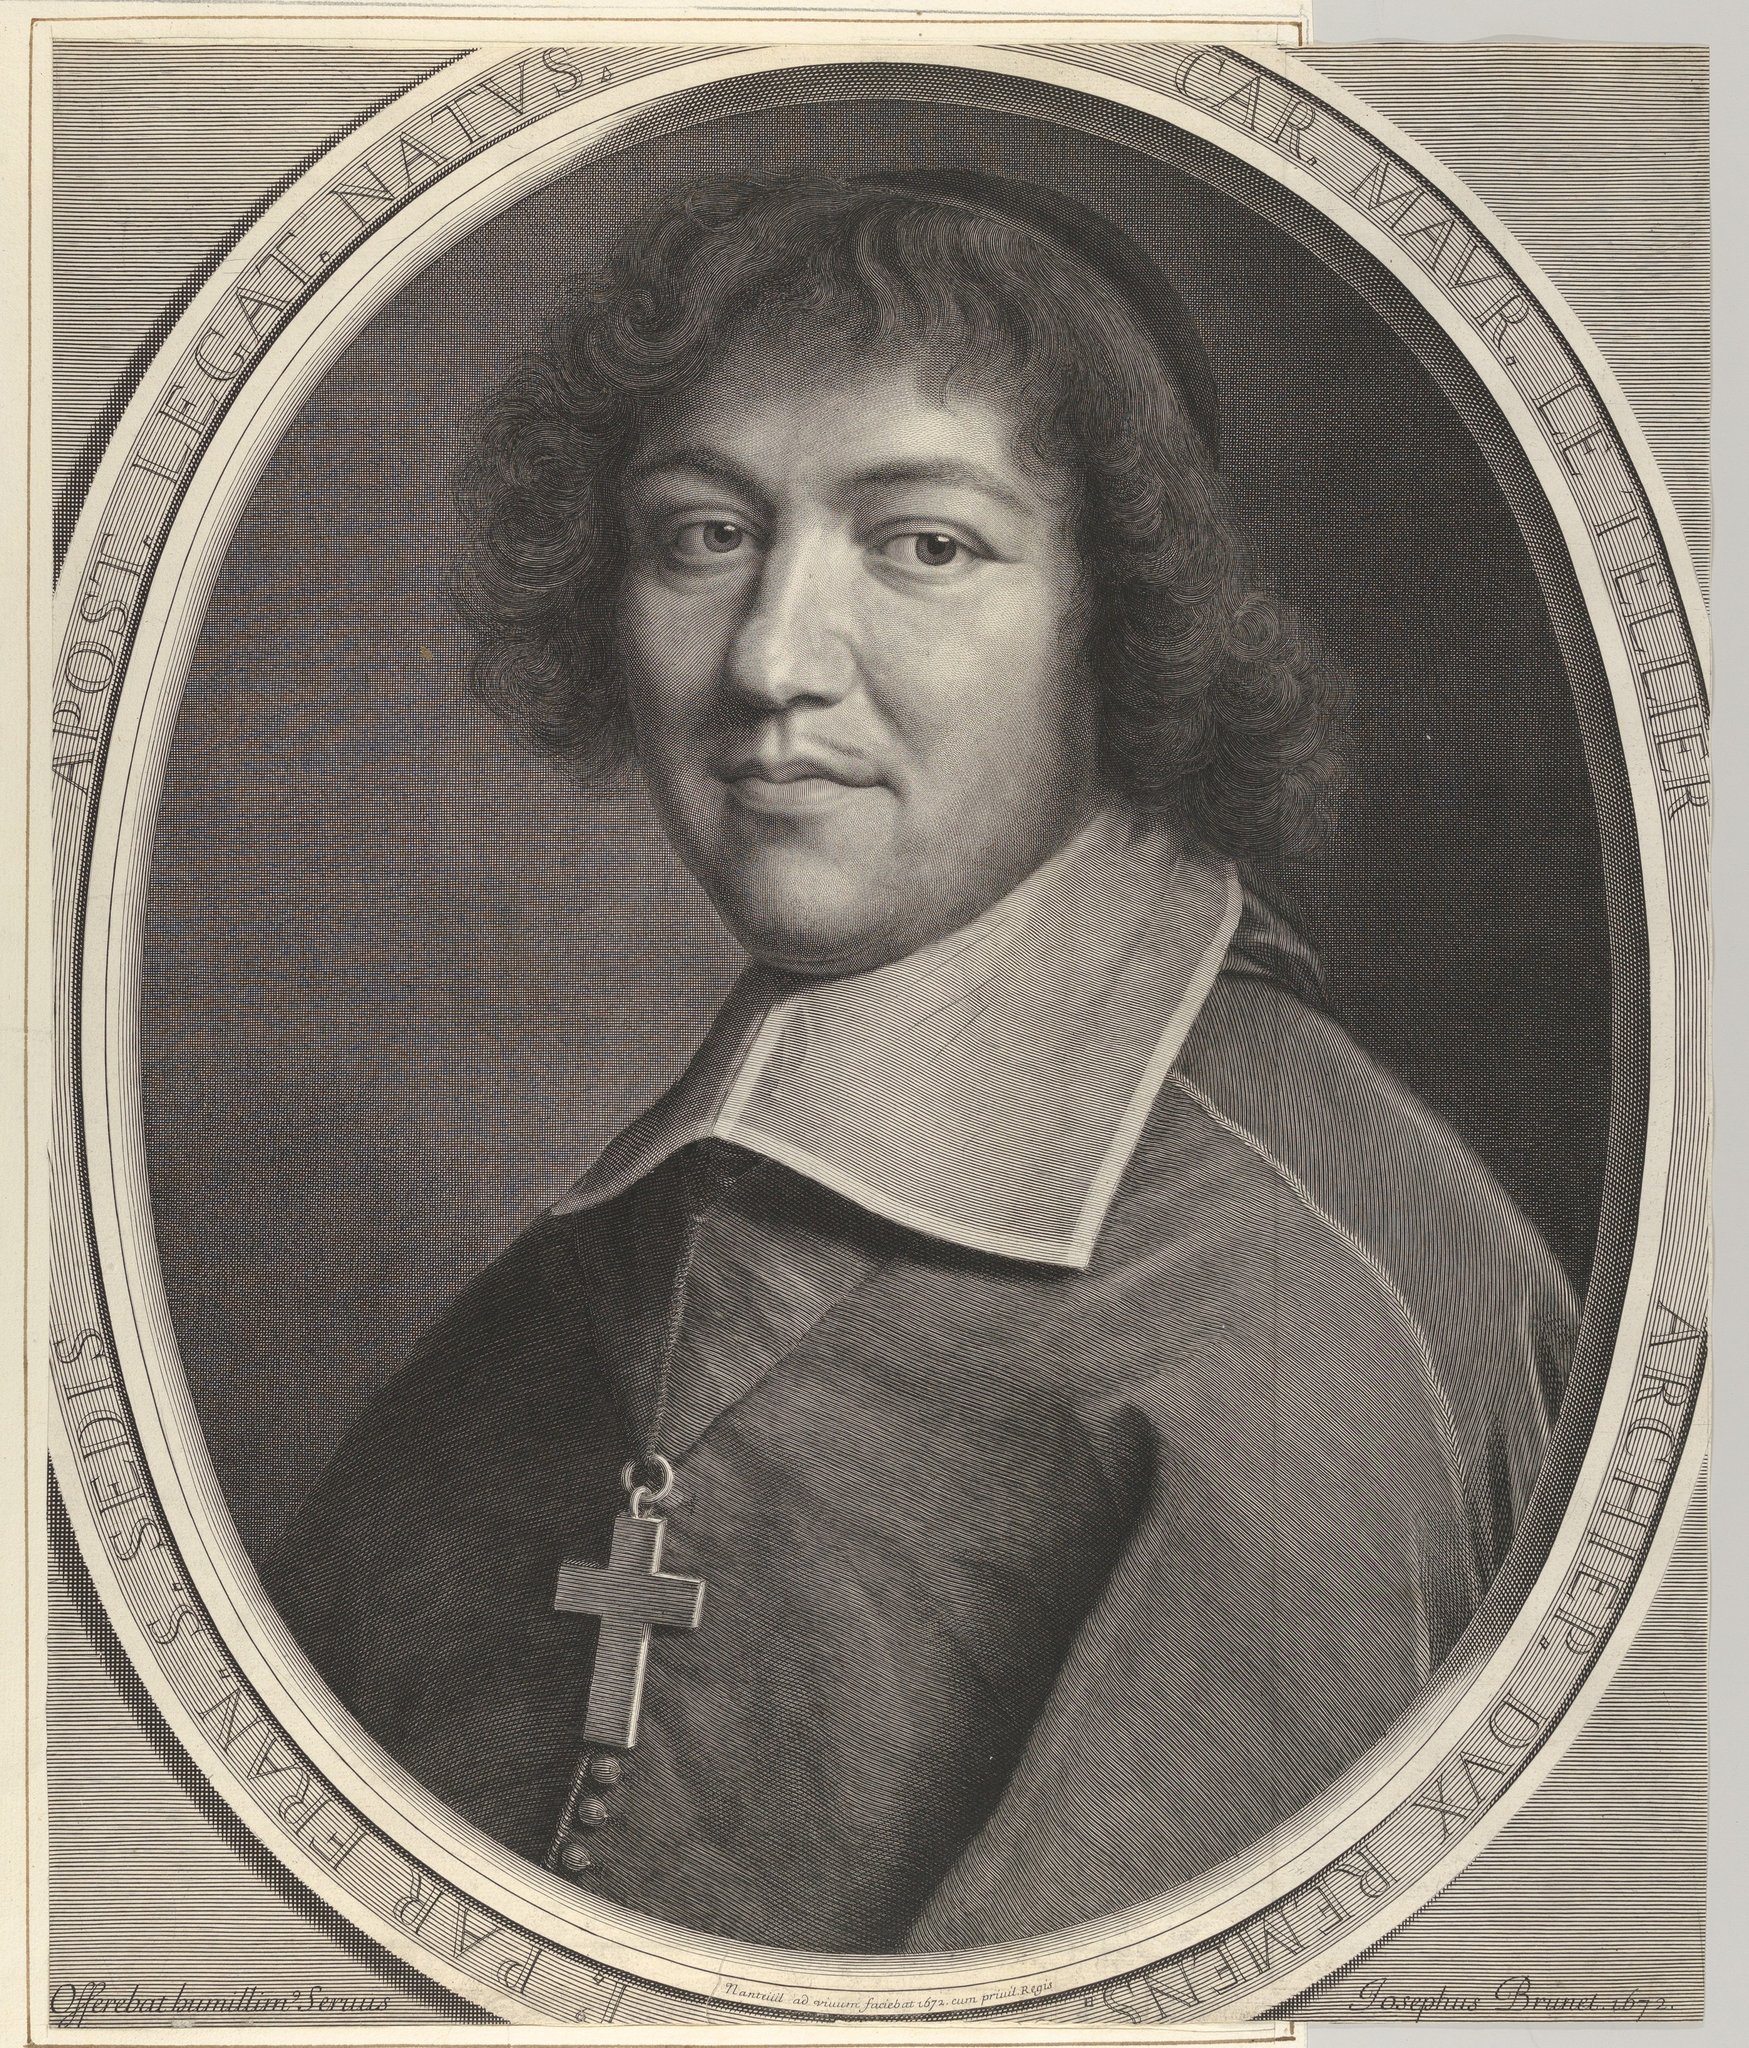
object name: print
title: Charles-Maurice Le Tellier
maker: robert nanteuil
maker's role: artist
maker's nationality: french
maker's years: 1623-1678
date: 1672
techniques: engraving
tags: men,portraits,cross